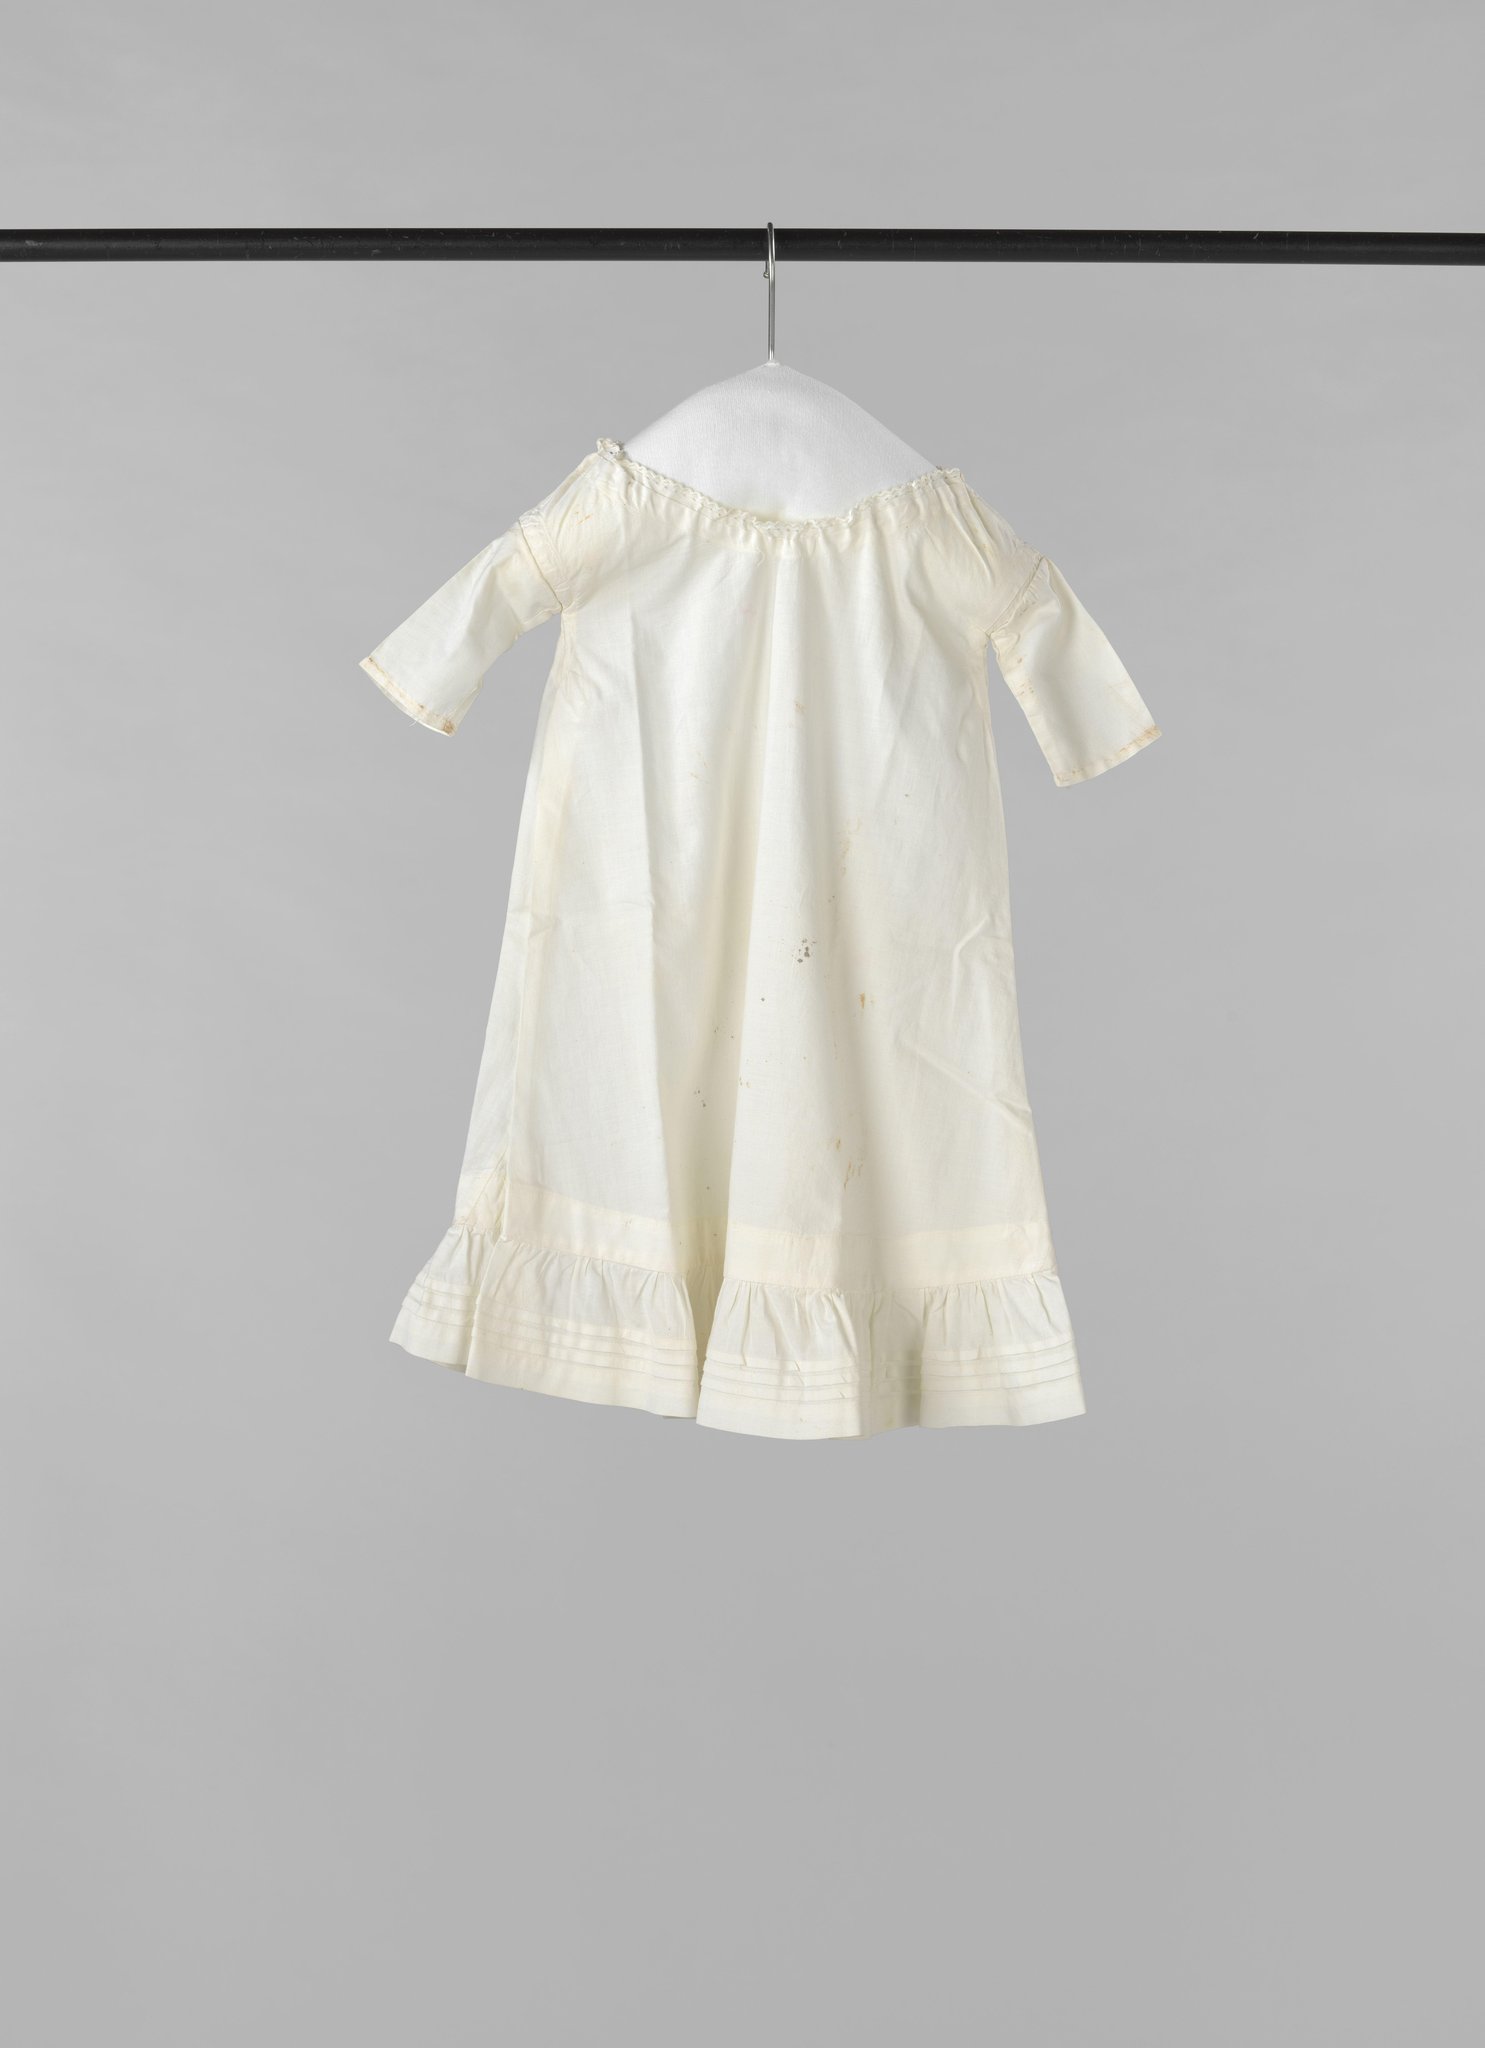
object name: clothing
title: Nachtpon voor een kind van witte katoen.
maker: Anonymous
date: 1880-1890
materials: cotton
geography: netherlands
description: Nachtpon voor een kind van witte katoen. Nederland, ca. 1885.